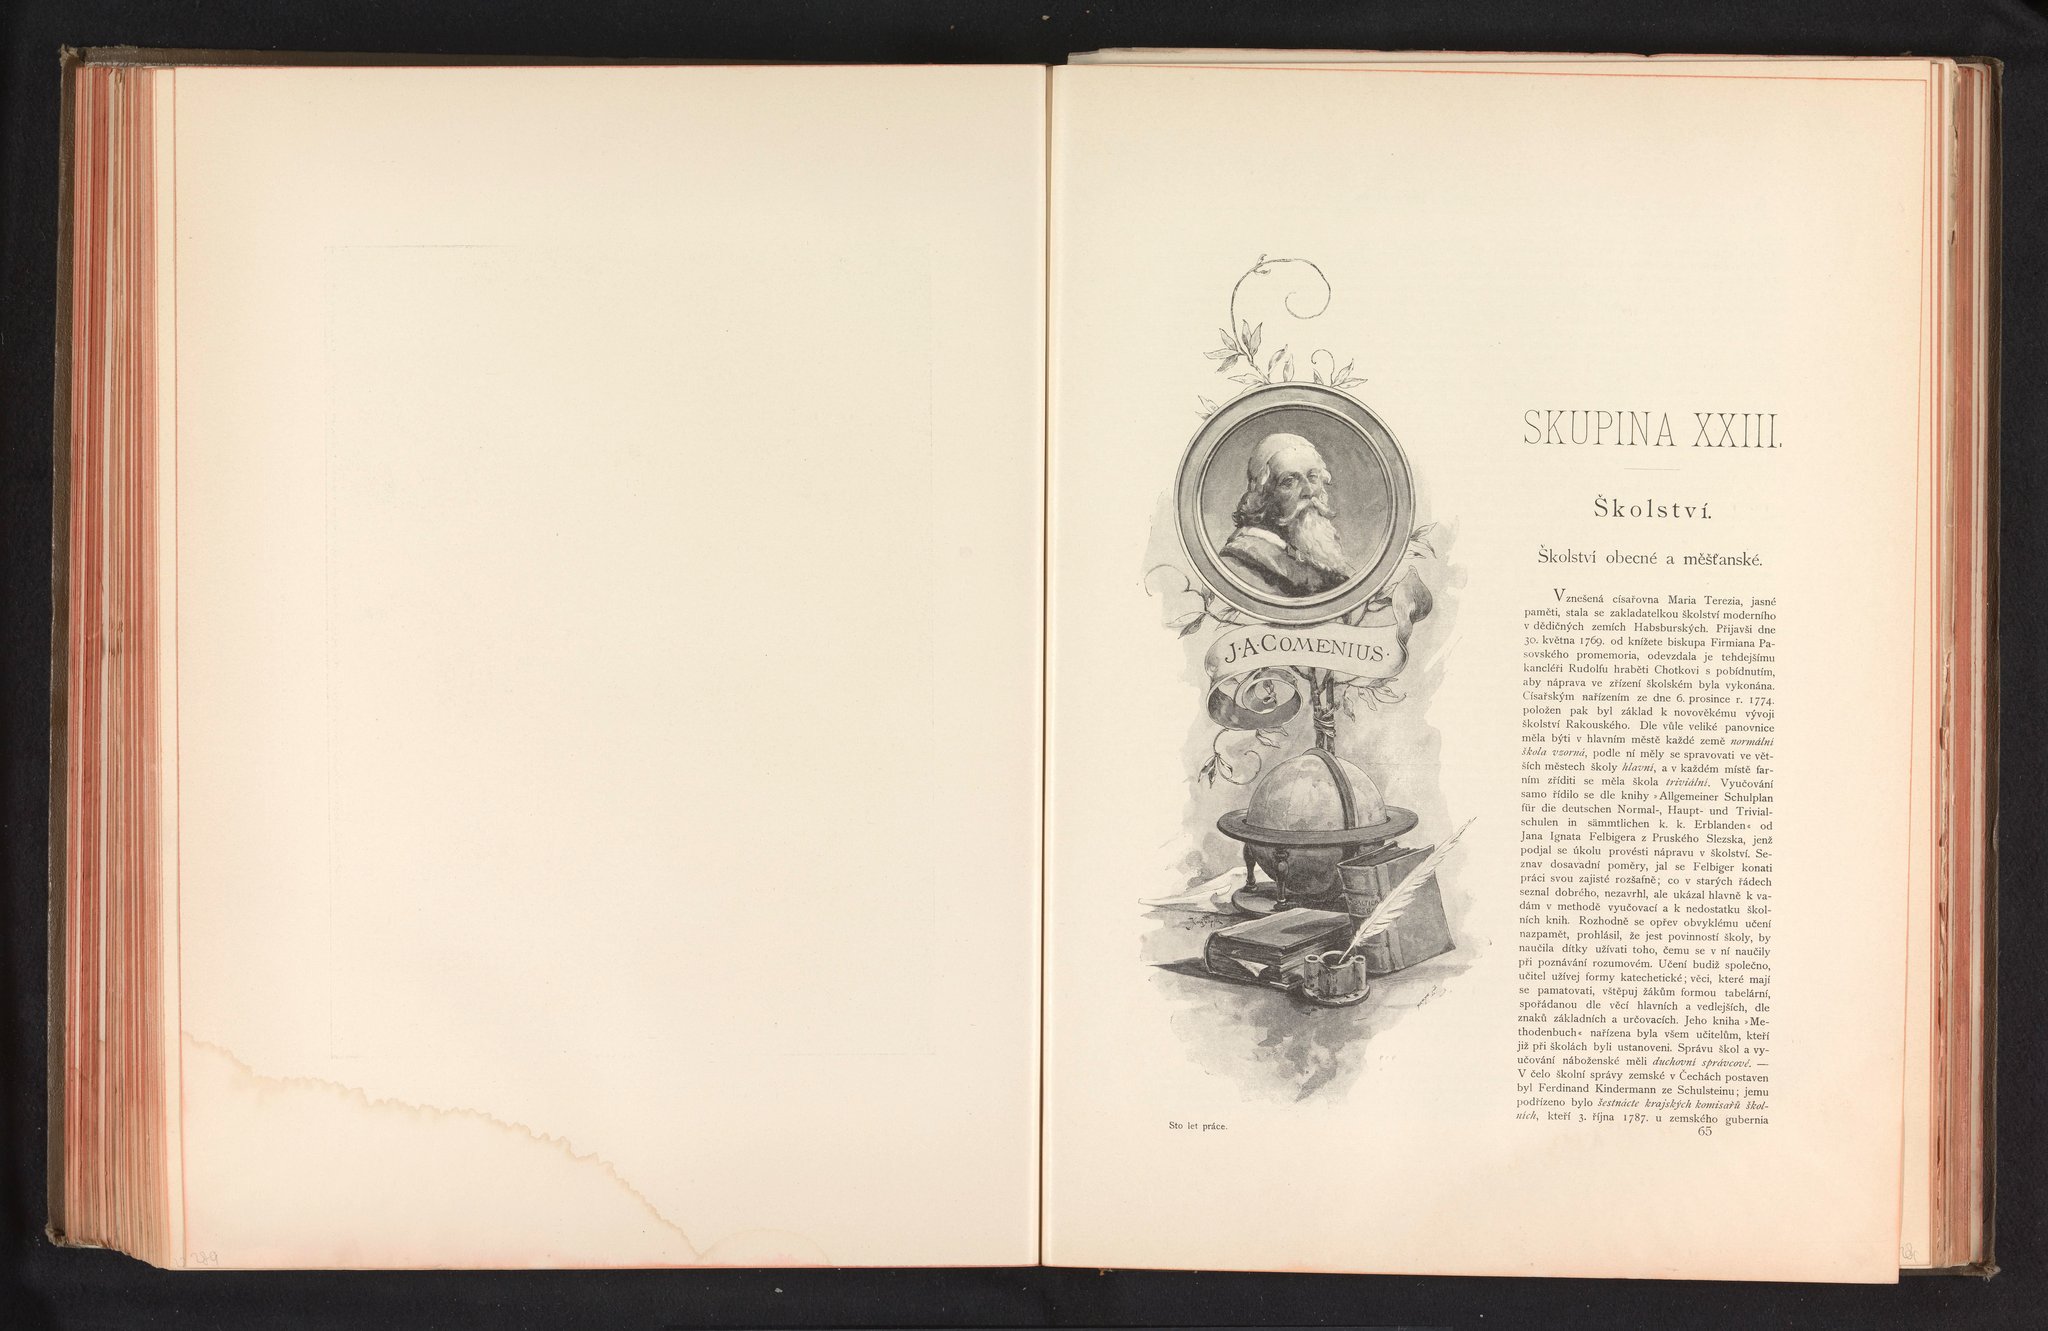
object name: page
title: Fotoreproductie van een tekening, voorstellende een portret van Jan Amos Comenius boven een globe en boeken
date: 1891-1895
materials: paper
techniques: autotype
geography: prague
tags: amsterdam, book, writer, poet, author, globe